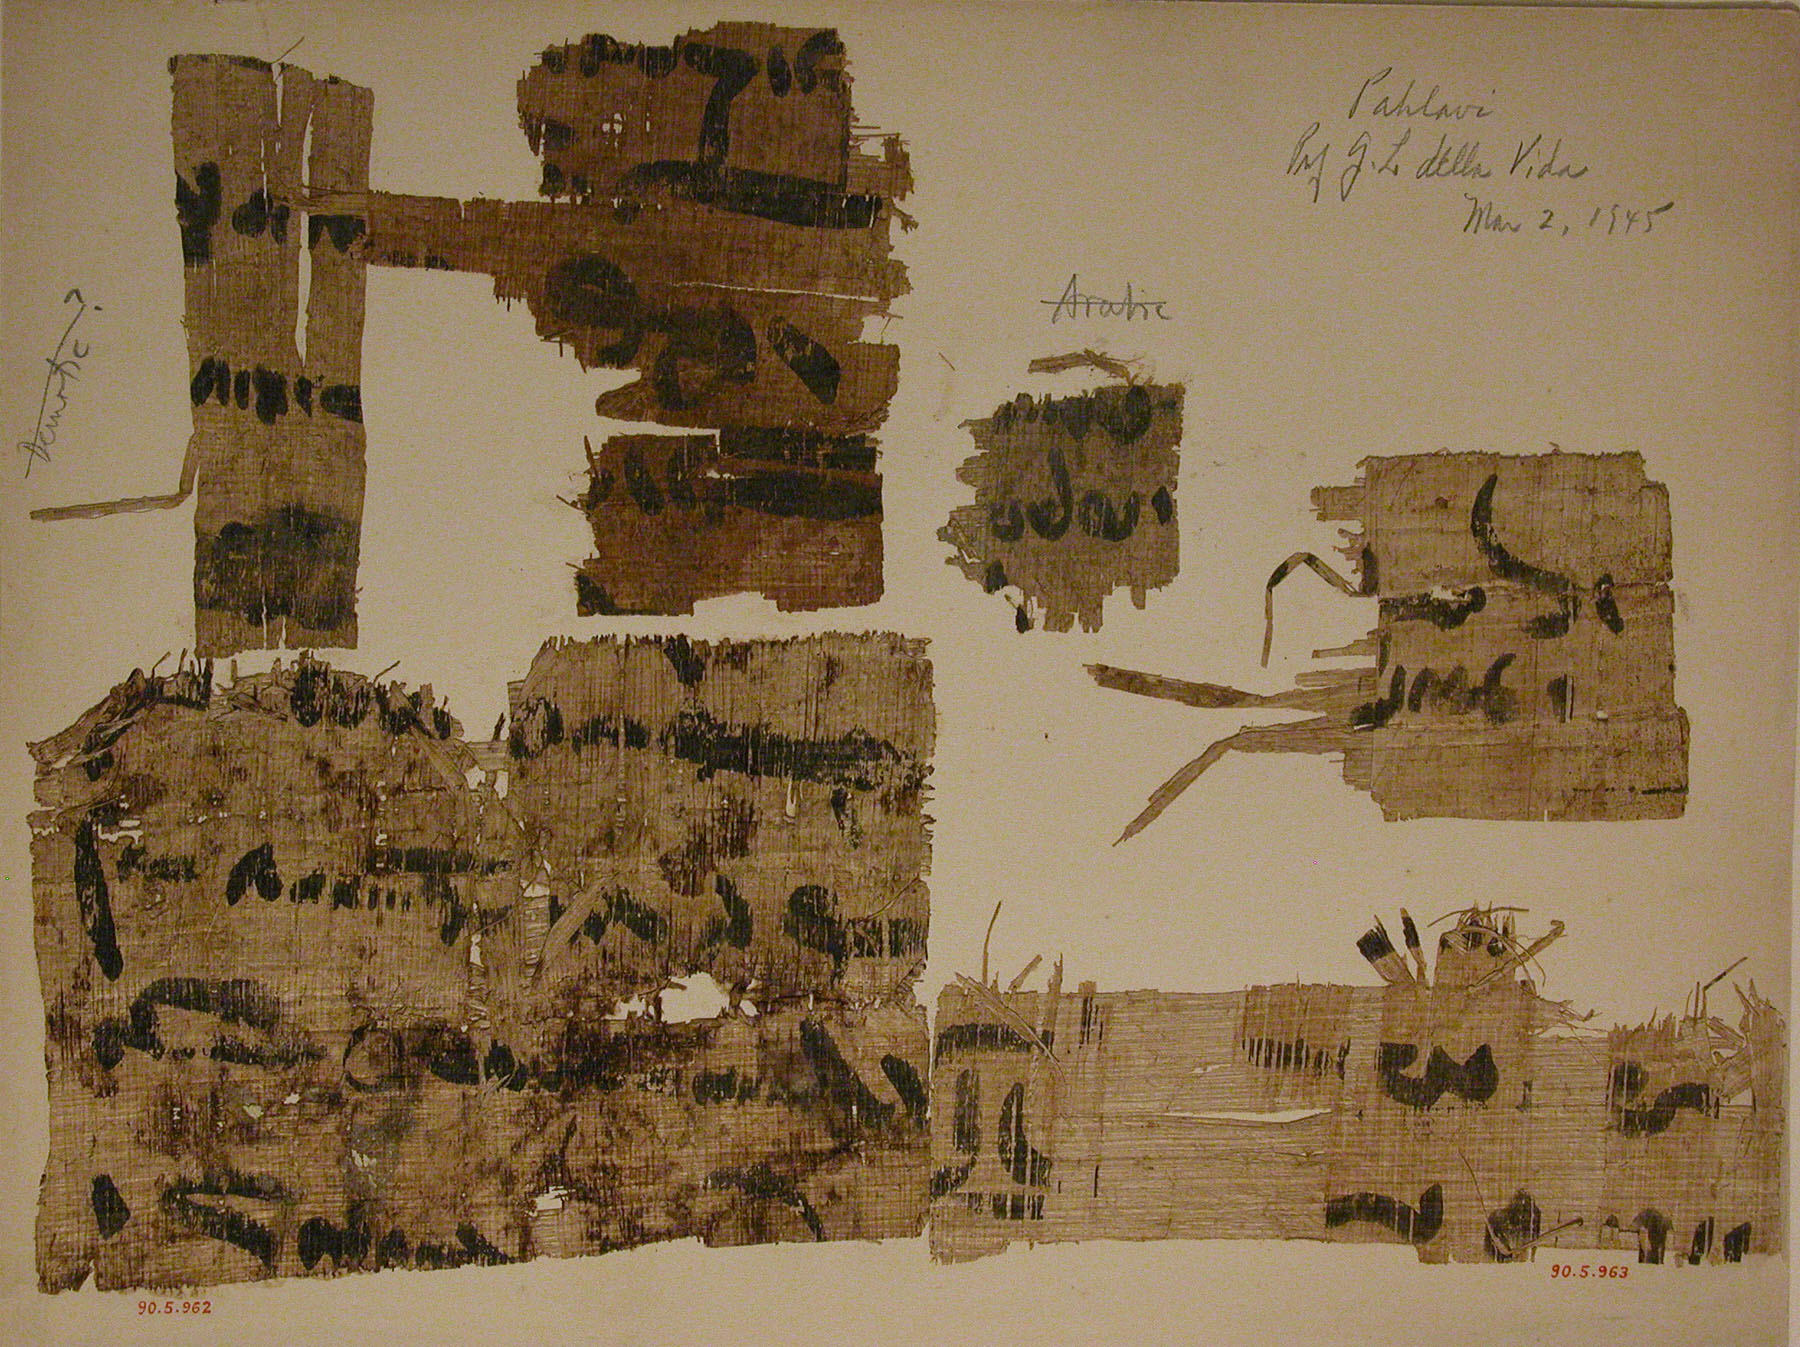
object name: non illustrated single work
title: Papyrus Fragments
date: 618-629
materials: ink, papyrus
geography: egypt